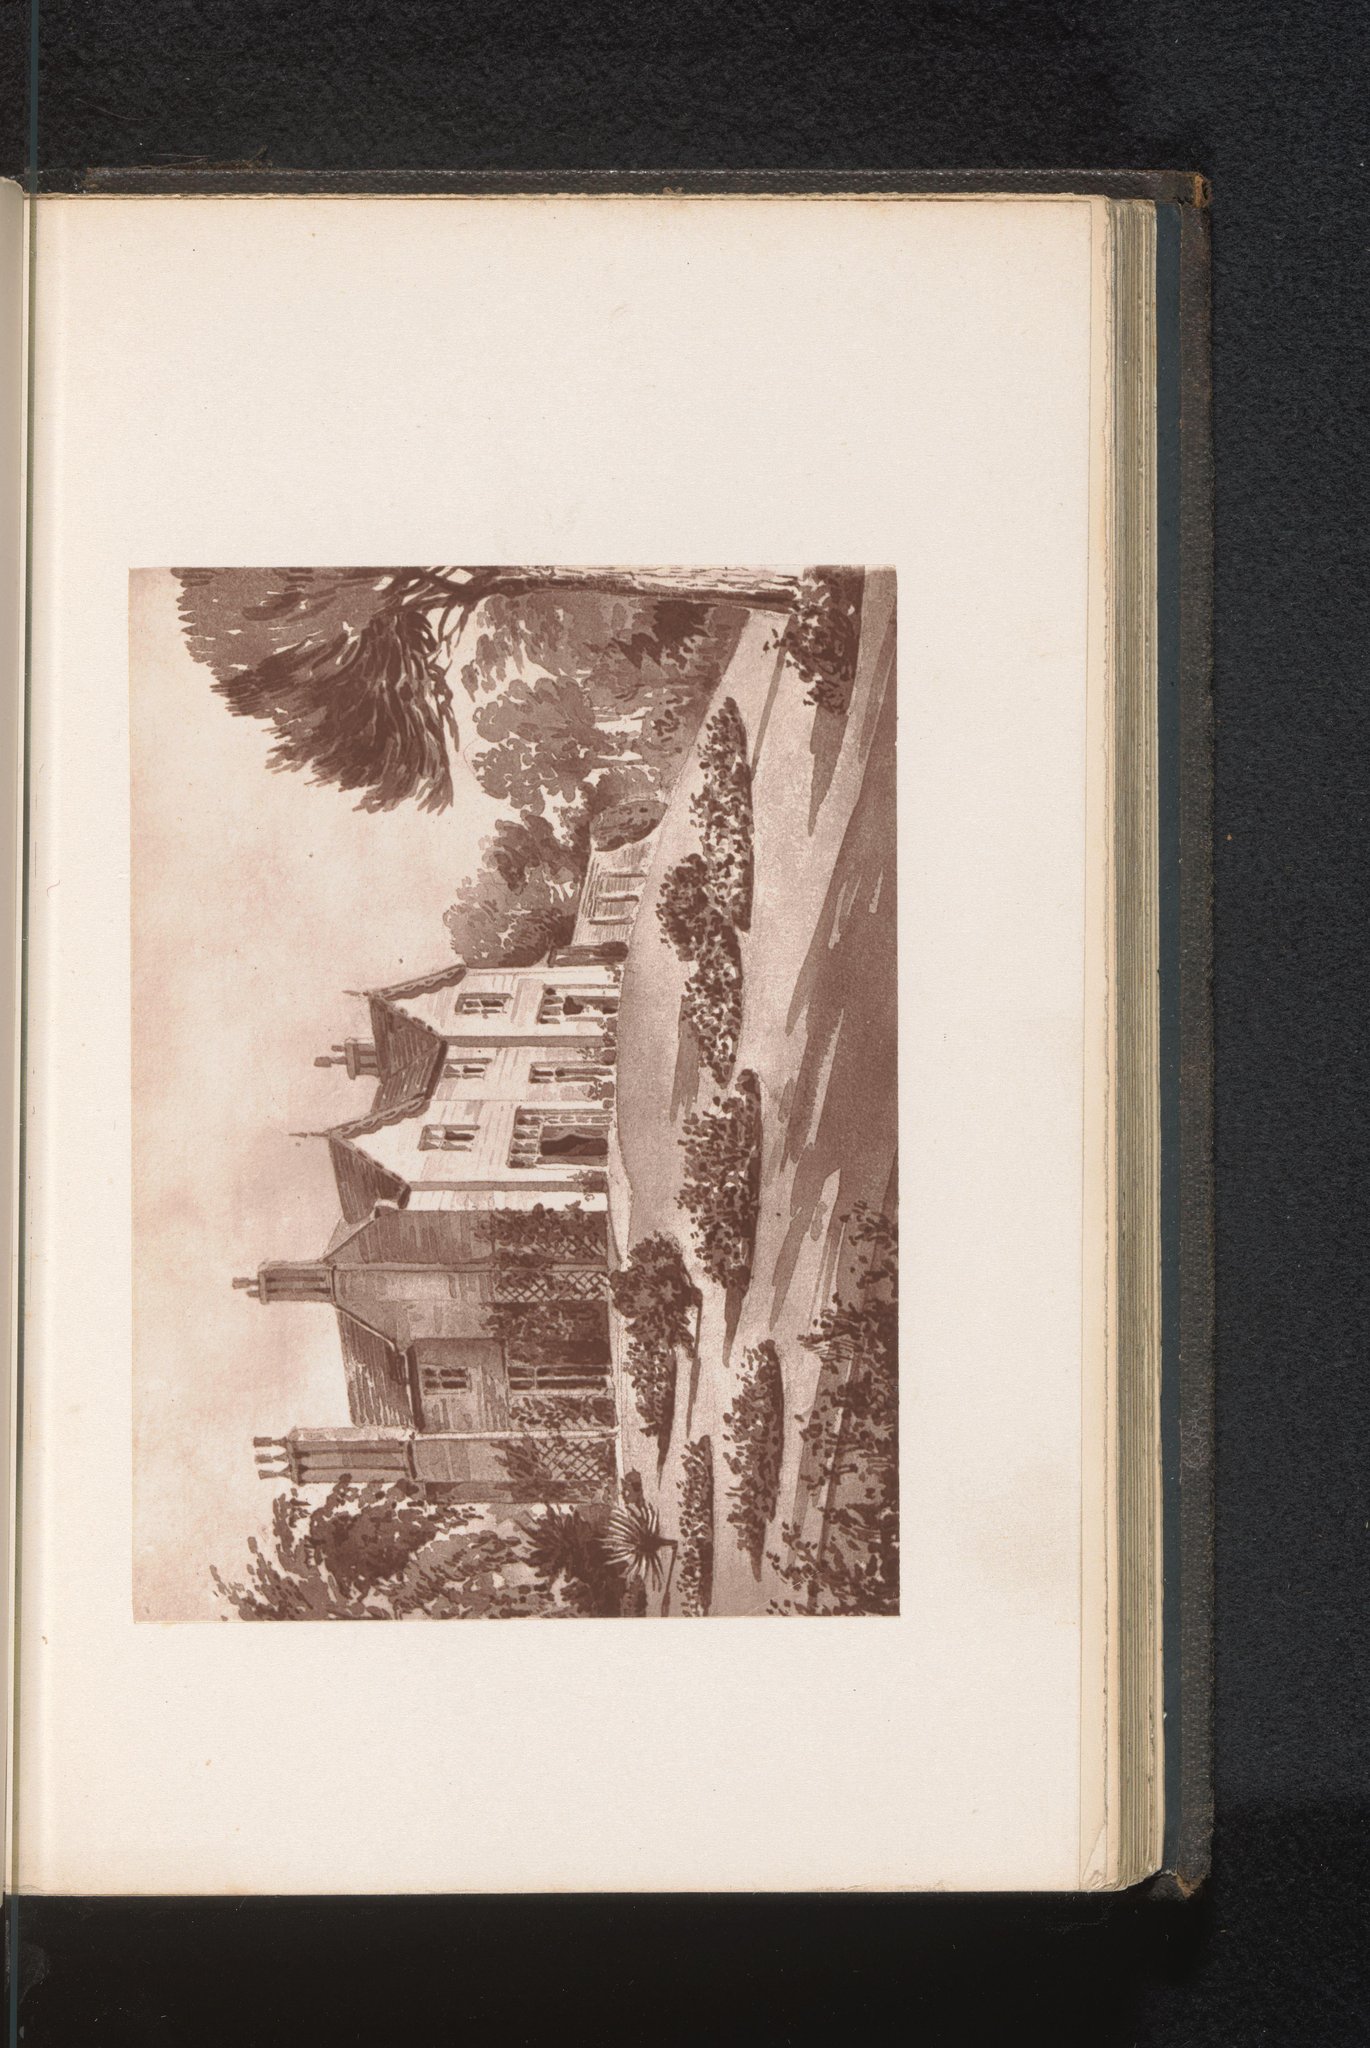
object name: photomechanical print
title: Fotoreproductie van een schildering, voorstellende een gezicht op Lime House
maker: Anonymous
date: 1866-1876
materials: paper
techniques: woodburytype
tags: rural housing, e.g. country-house, villa, cottage, façade (of house or building)